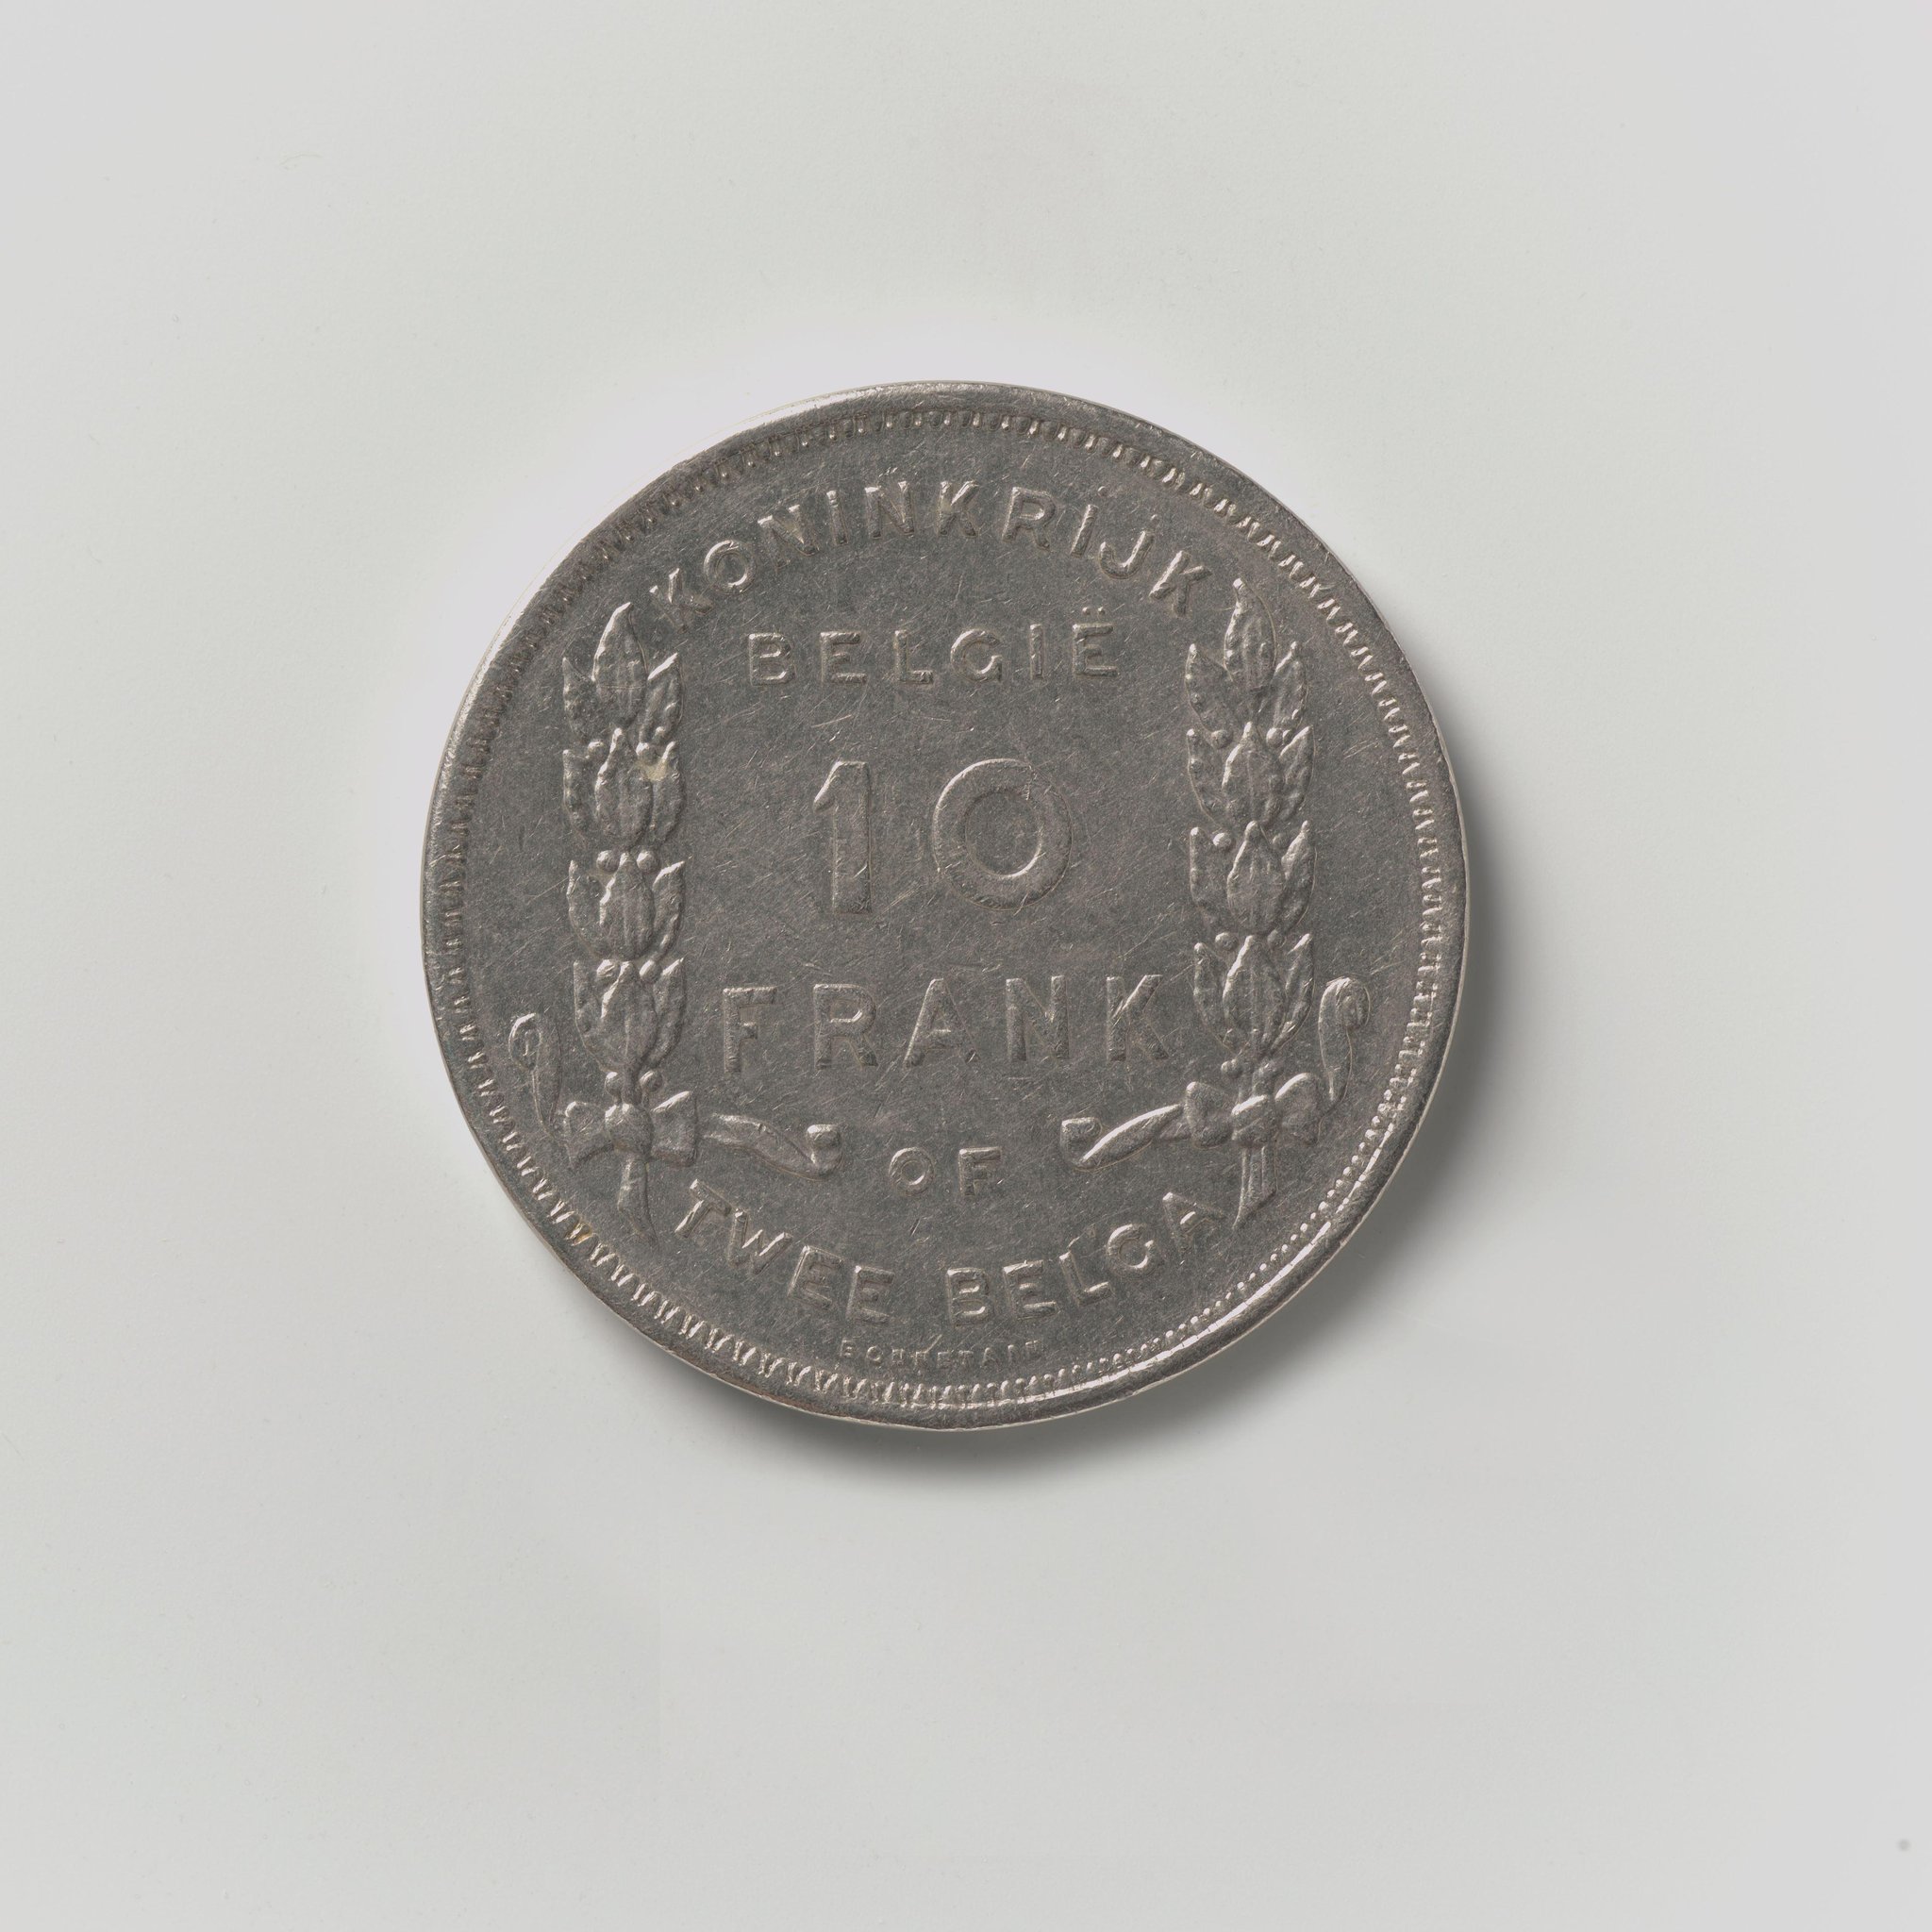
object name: coin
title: België, Albert I, 10 frank of 2 belga, 1930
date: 1930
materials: nickel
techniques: striking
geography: brussels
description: Nikkelen munt. Voorzijde: drie borstbeelden naar links. Jaartallen 1830-1930 onderaan. Keerzijde:tussen twee takken waarde-aanduiding in twee regels en in omschrift. Randschrift.